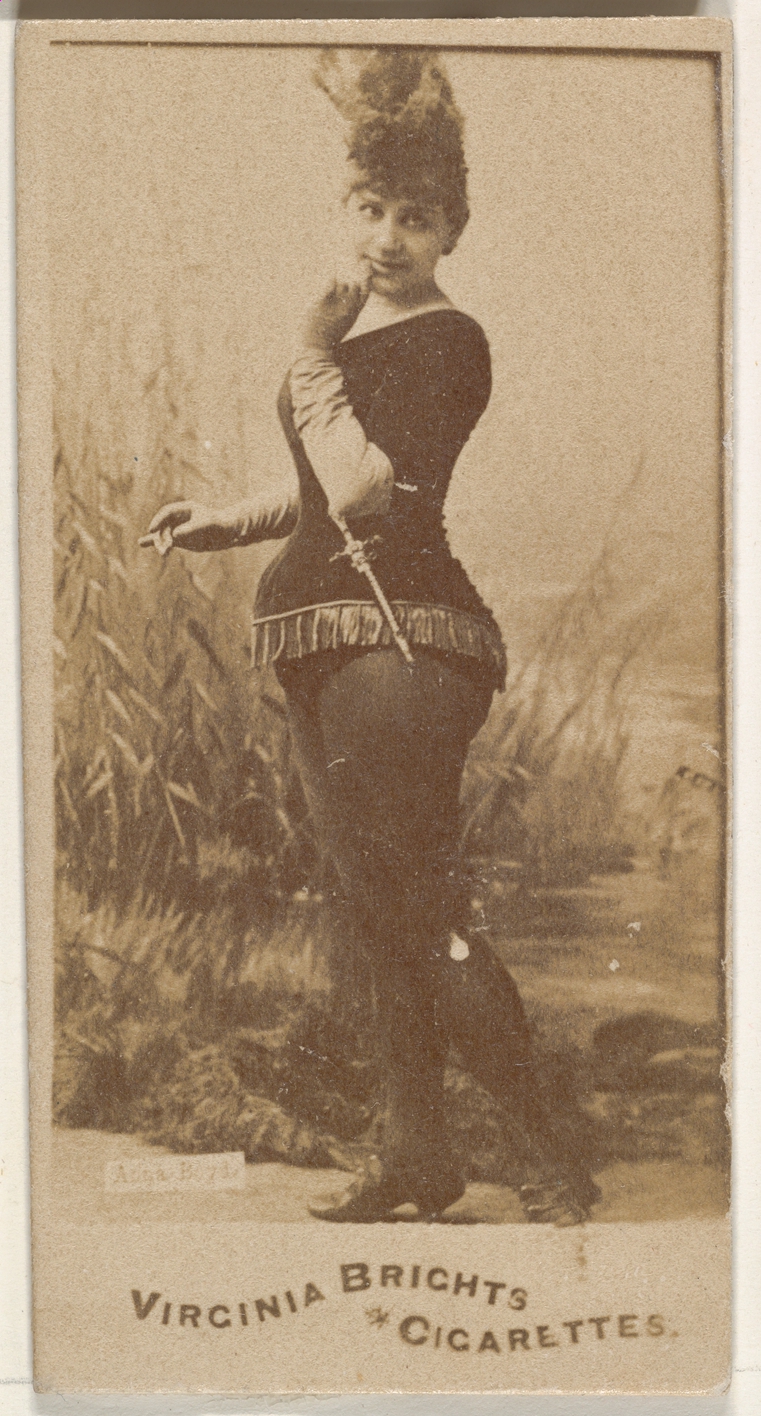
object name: photograph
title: From the Actors and Actresses series (N45, Type 1) for Virginia Brights Cigarettes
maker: allen & ginter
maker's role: publisher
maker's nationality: american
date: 1888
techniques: albumen silver print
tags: portraits,women,actresses